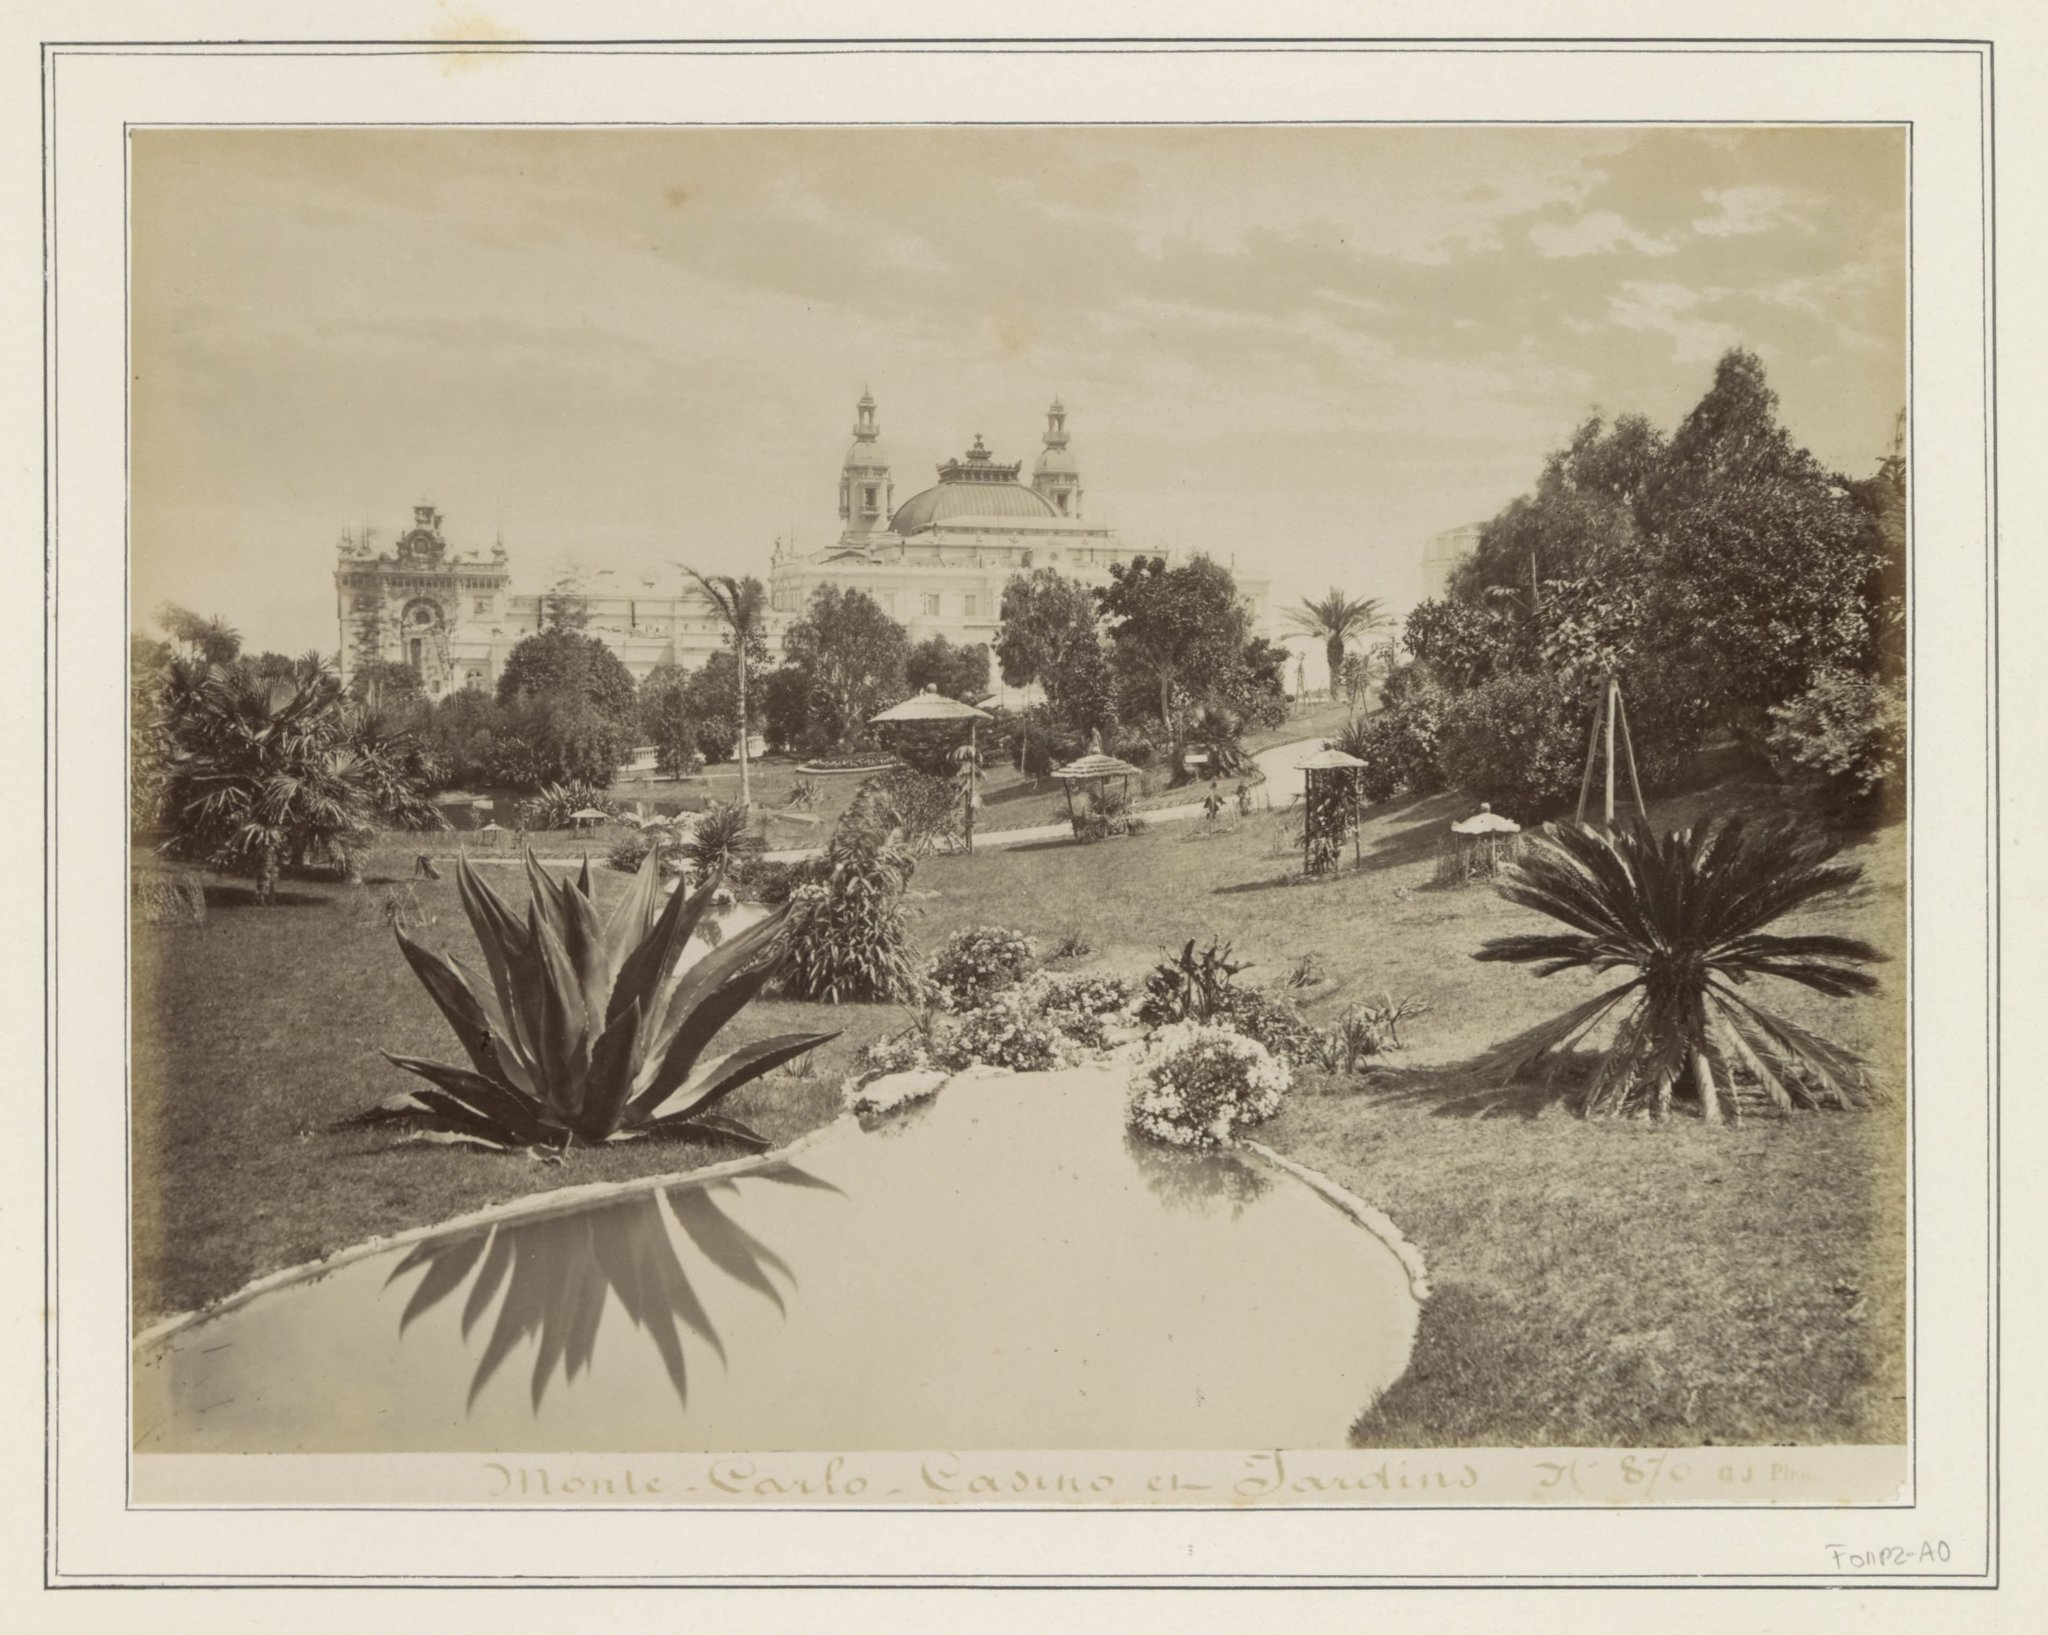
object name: photograph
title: Monte-Carlo, Casino et Jardins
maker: gj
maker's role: fotograaf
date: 1860-1890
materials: paper, photographic support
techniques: albumen print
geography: monaco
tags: casino, public gardens, park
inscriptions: negative number: ‘870’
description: Onderdeel van Reisalbum met foto's van bezienswaardigheden in Italië en aan de Franse Rivièra (deel II).